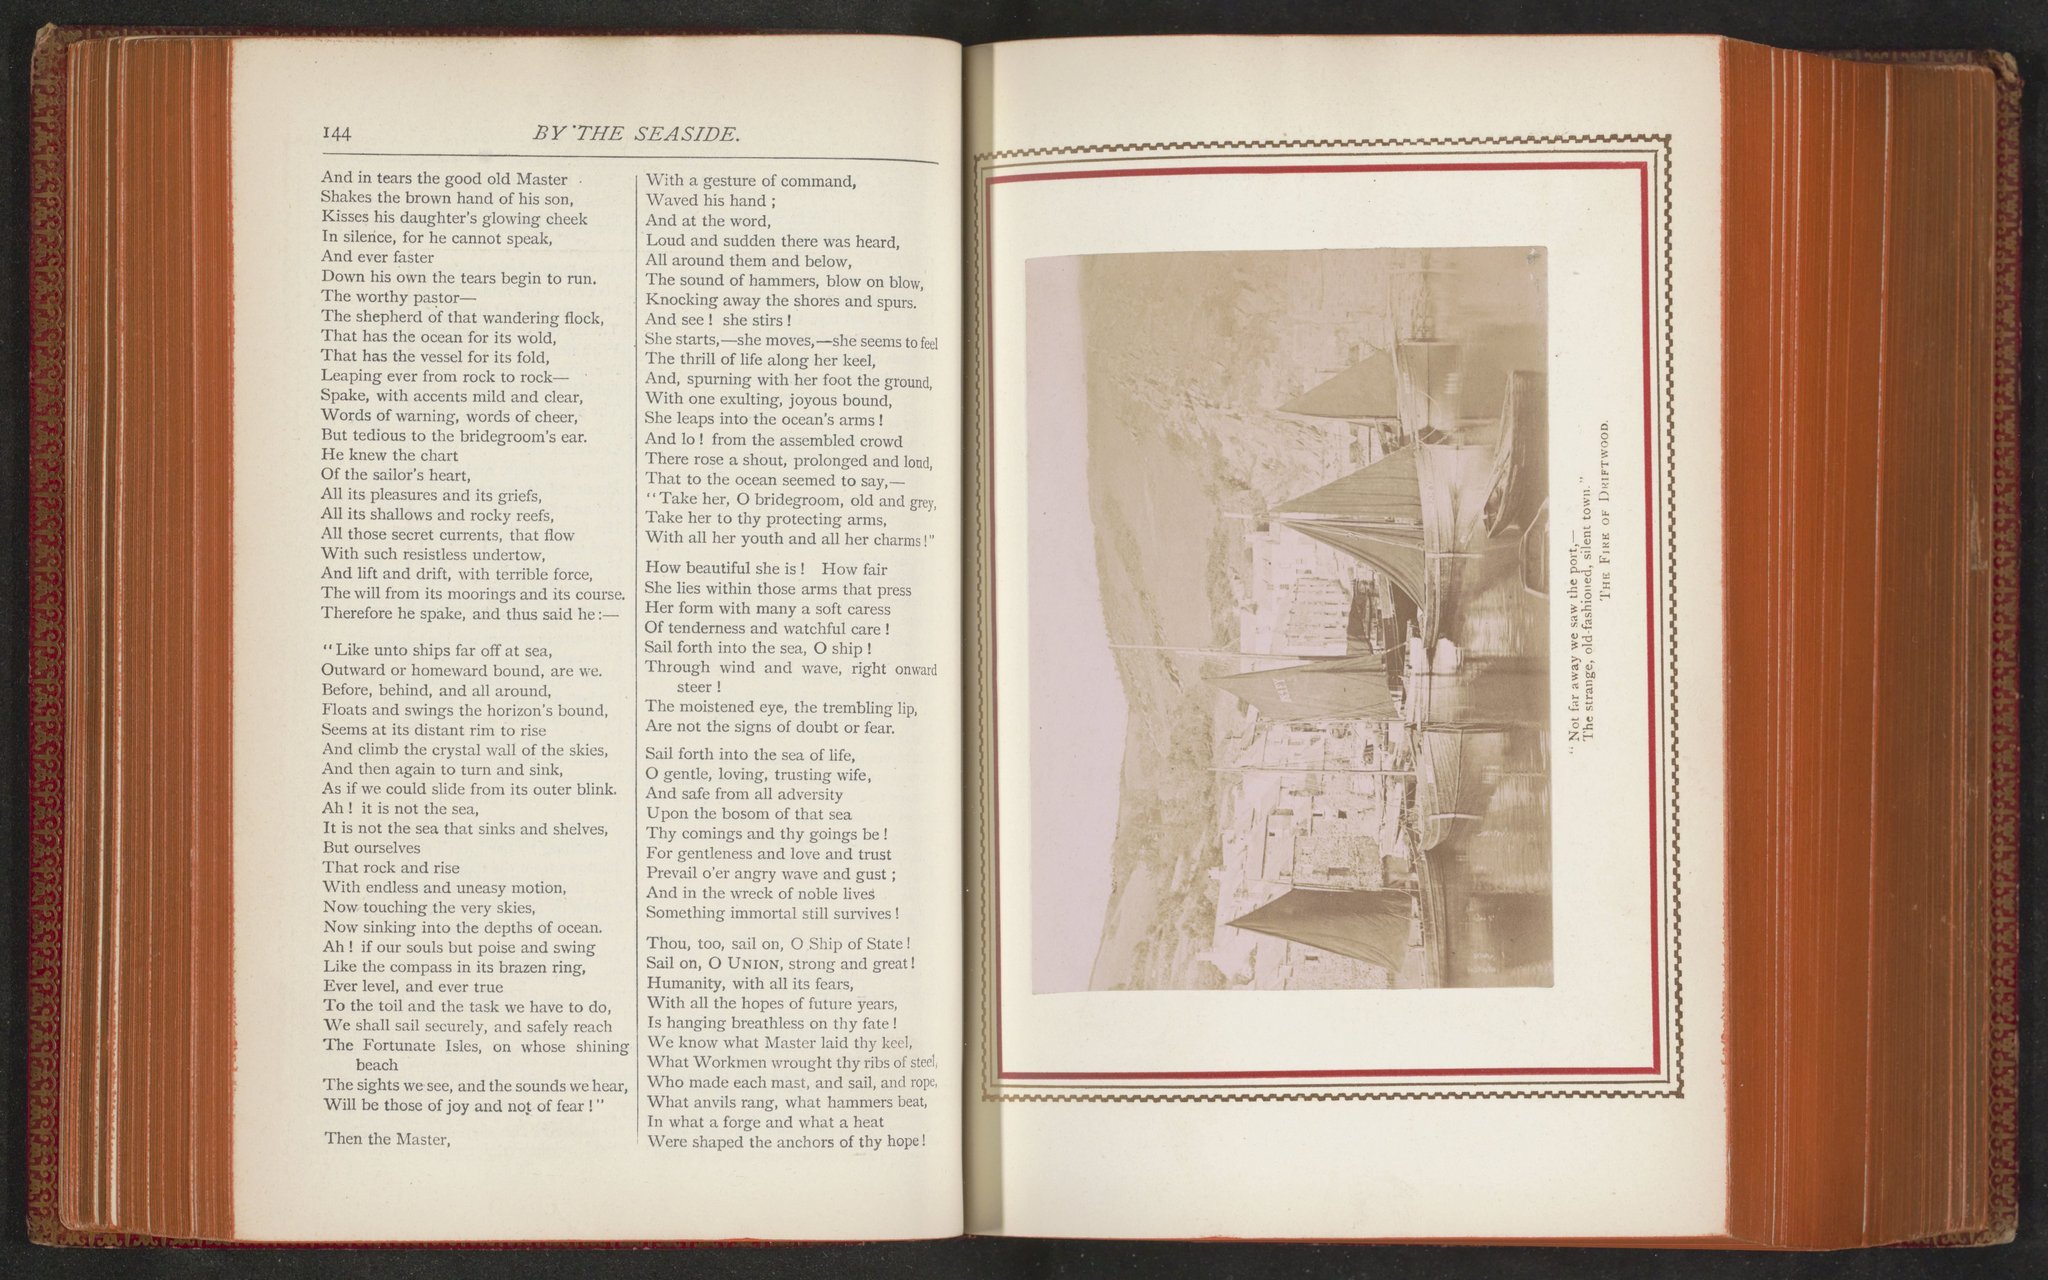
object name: photograph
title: Gezicht op zeilboten in een haven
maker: Anonymous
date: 1872-1882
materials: photographic support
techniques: albumen print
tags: harbour, sailing-ship, sailing-boat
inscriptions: inscription: ‘" Not far away we saw the port.- The strange, old-fashioned, silent town."’